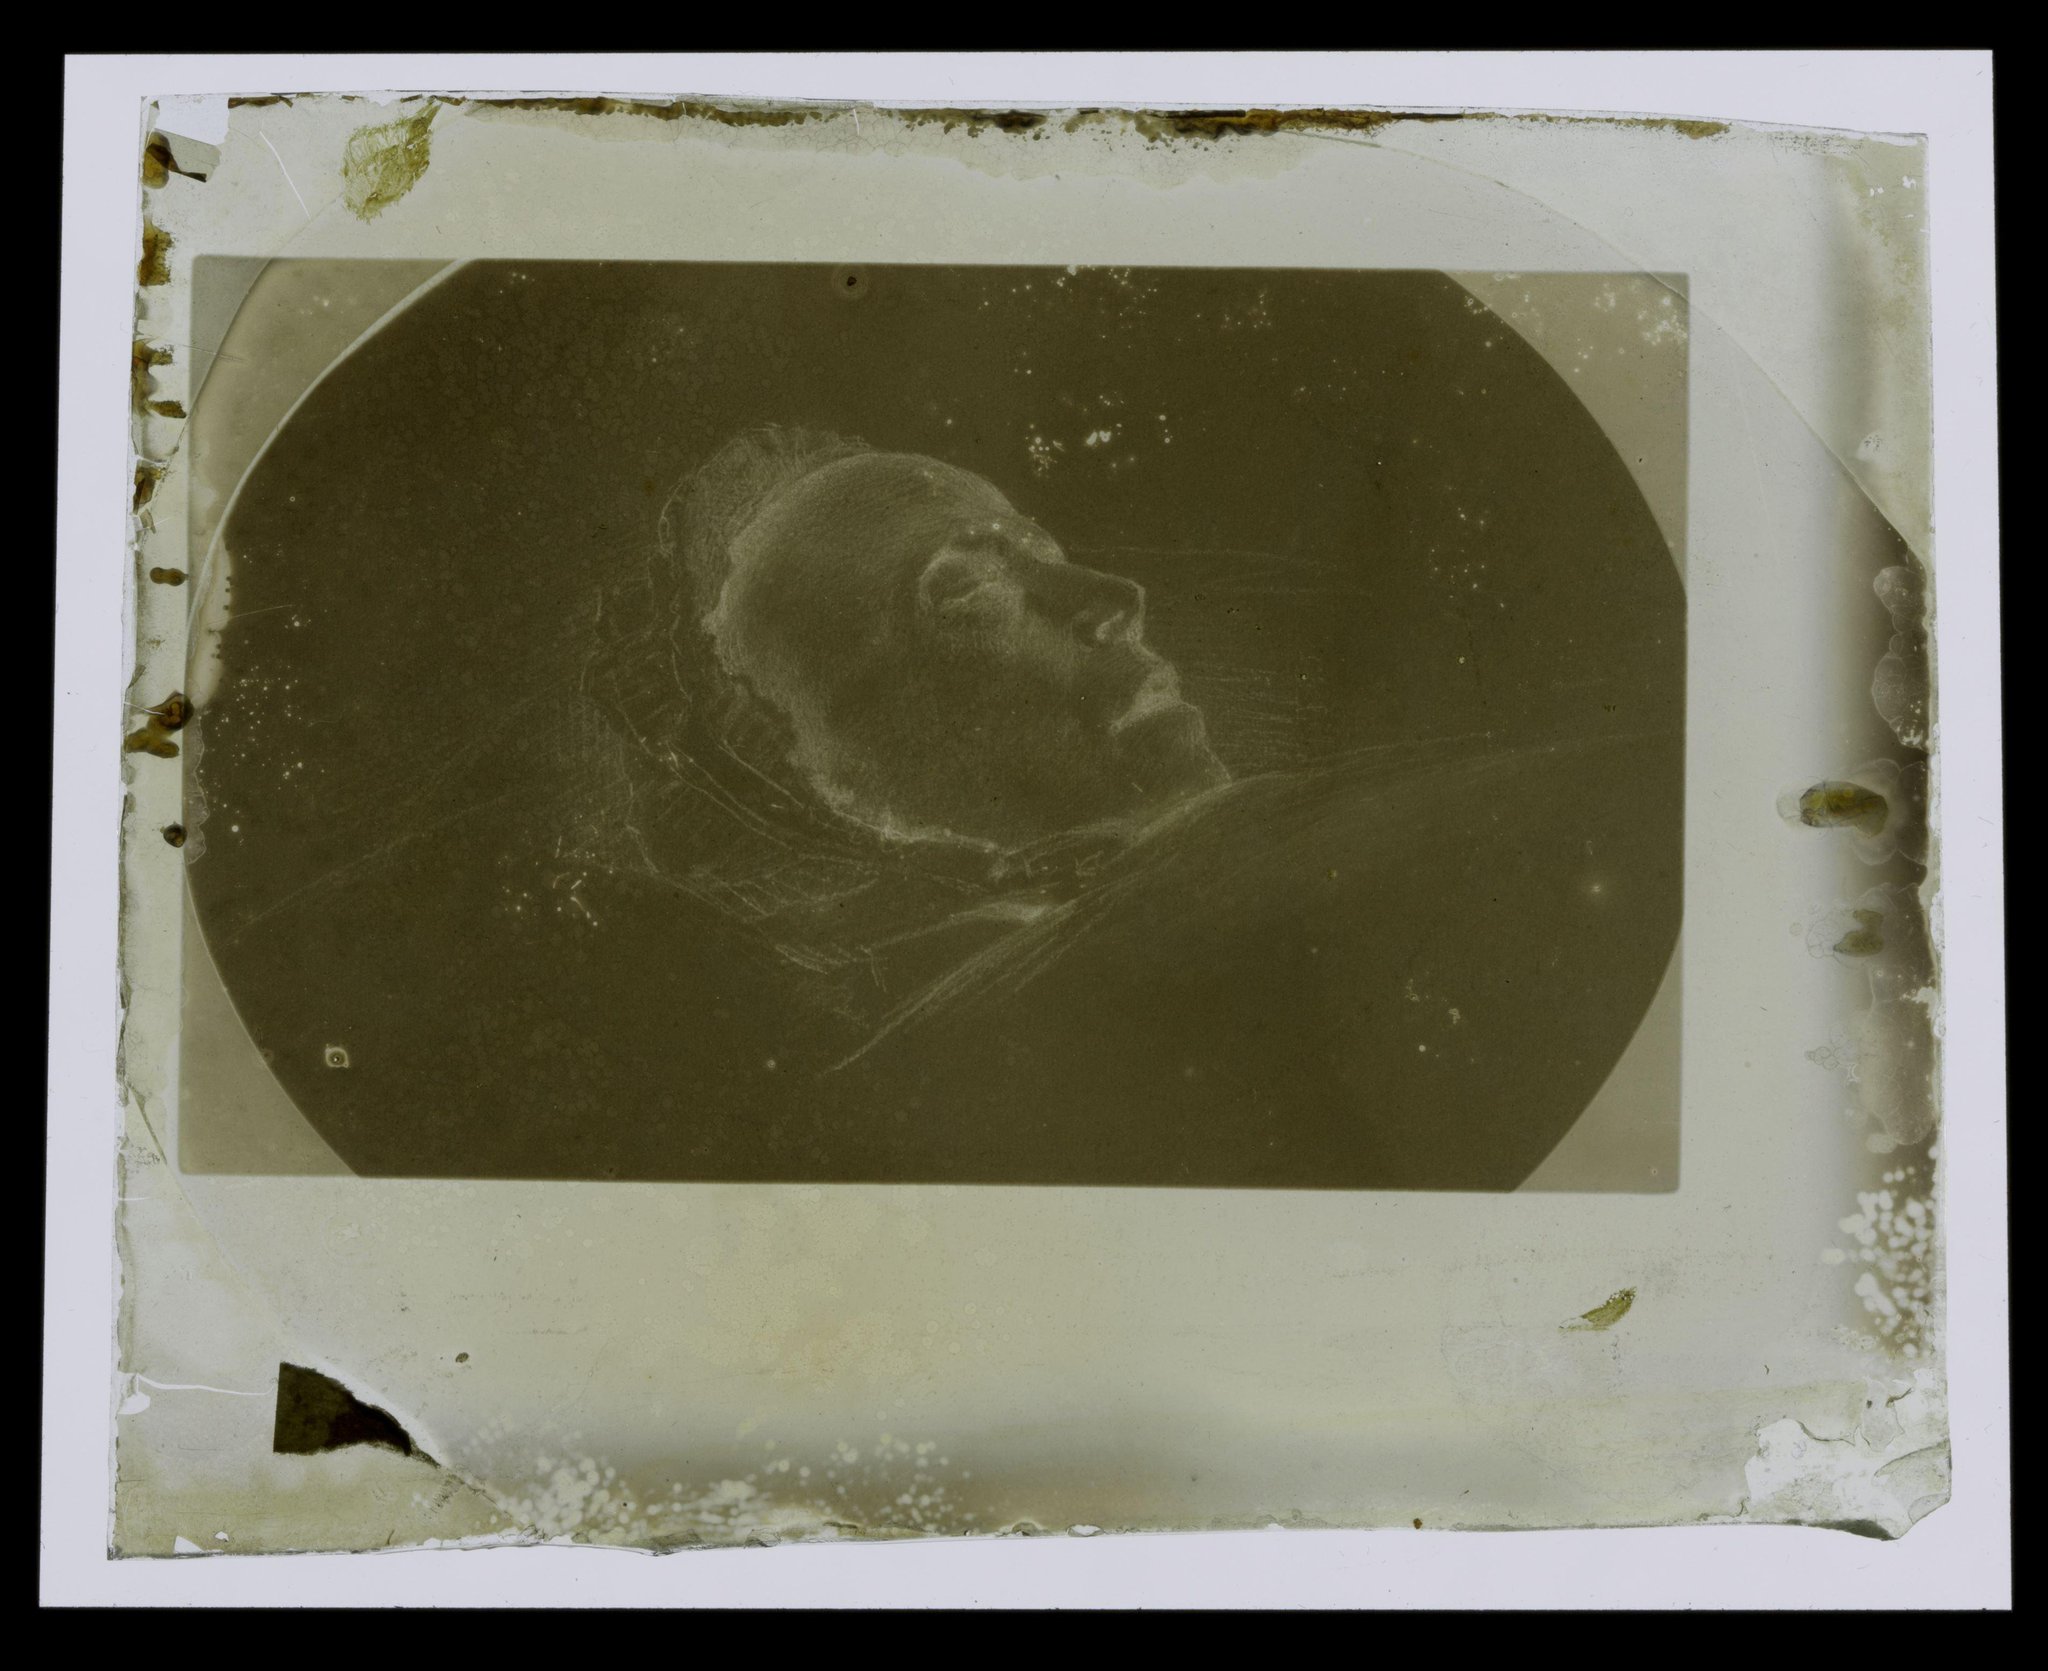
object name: glasnegatief, glasplaatnegatief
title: Fotoreproductie van een getekend post-mortem portret van een onbekende vrouw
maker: laurens lodewijk kleijn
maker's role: draughtsman, painter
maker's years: 1826-1909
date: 1865-1900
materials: glass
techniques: collodion process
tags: anonymous historical person portrayed - bb - woman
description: Onderdeel van een groep glasnegatieven uit de nalatenschap van de schilder Laurens Lodewijk Kleijn, met stillevens, portretten, zelfportretten en kunstreproducties.